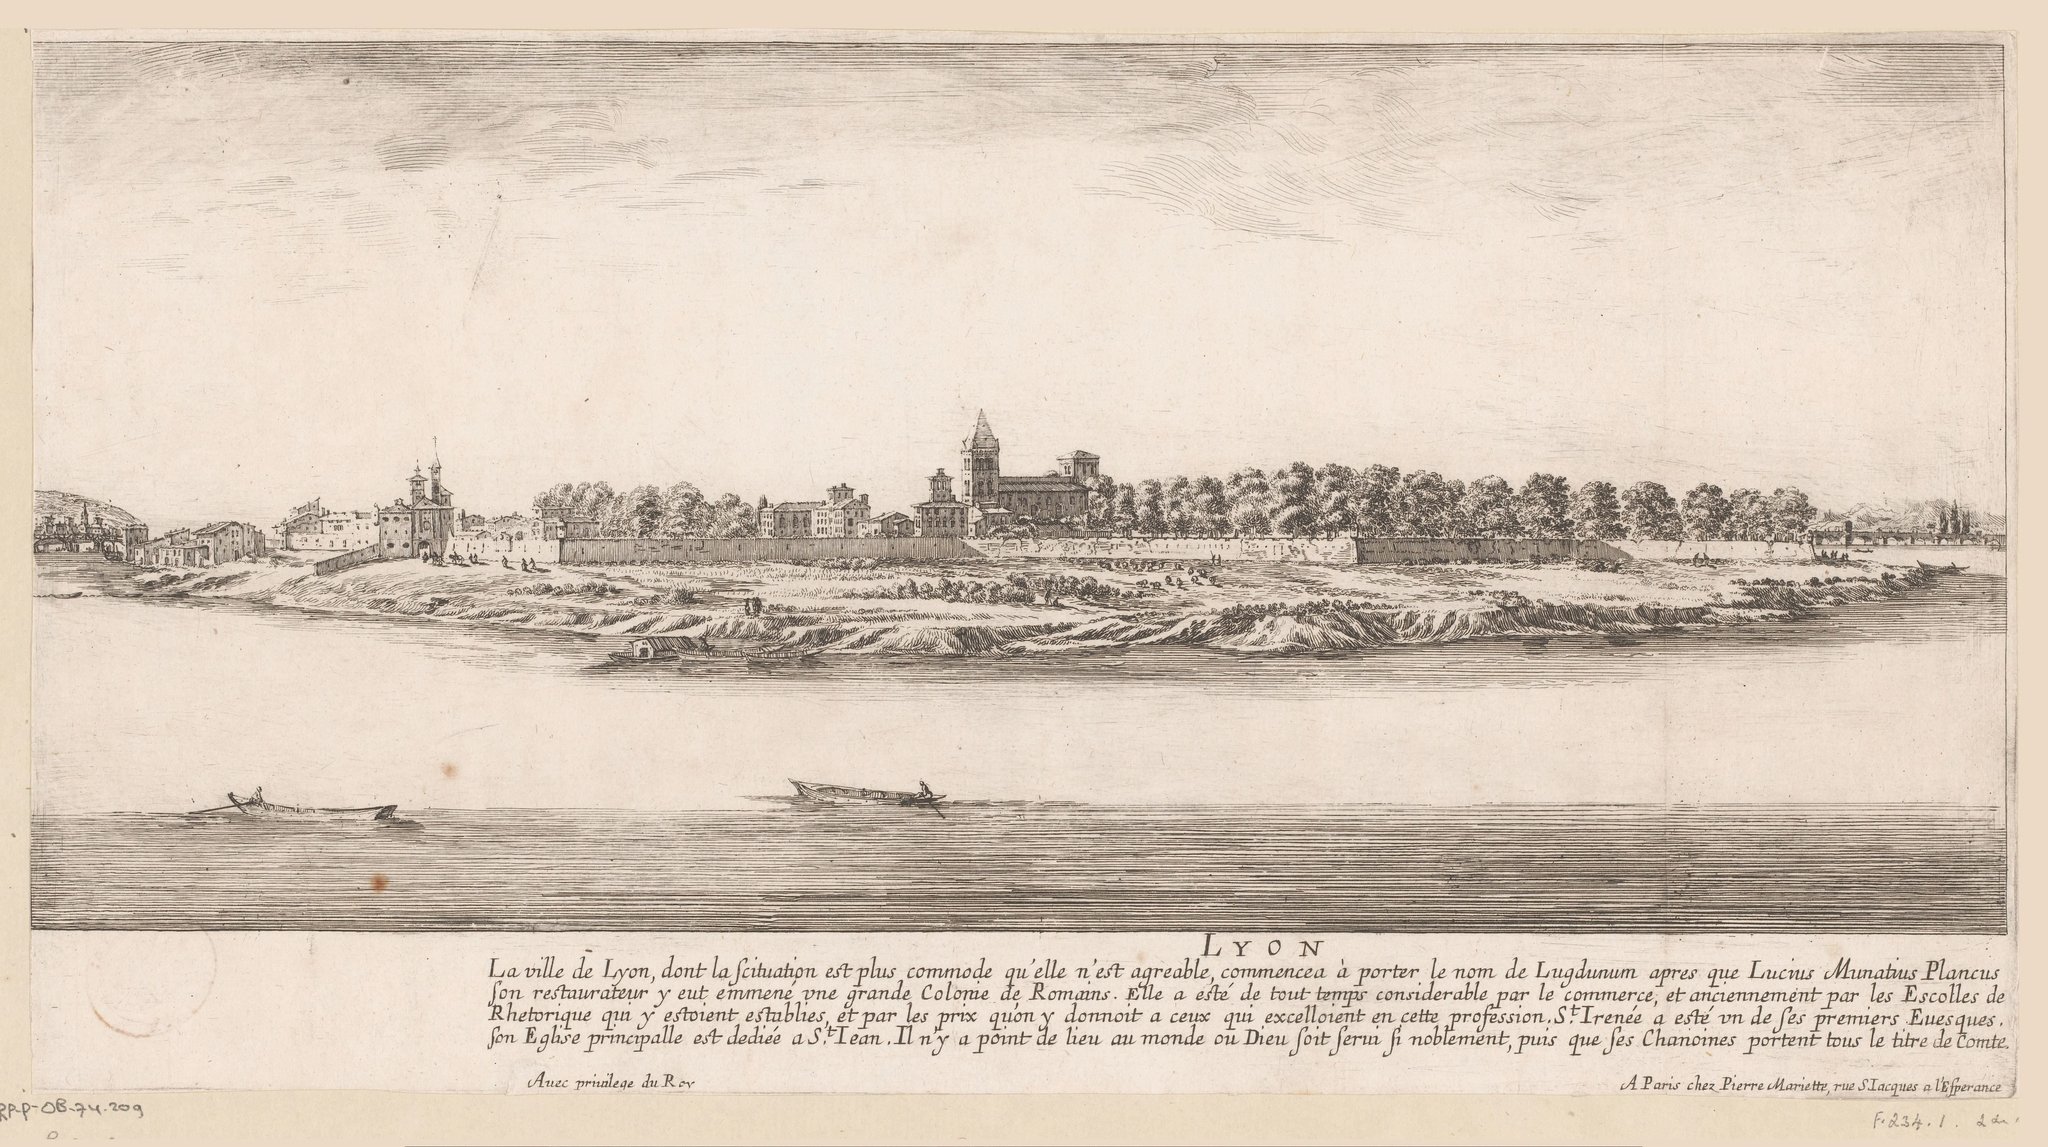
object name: print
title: Profiel van de stad Lyon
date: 1631-1691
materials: paper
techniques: engraving, etching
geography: paris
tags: city-view, and landscape with man-made constructions, lyon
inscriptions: collector's mark: Lugt 240